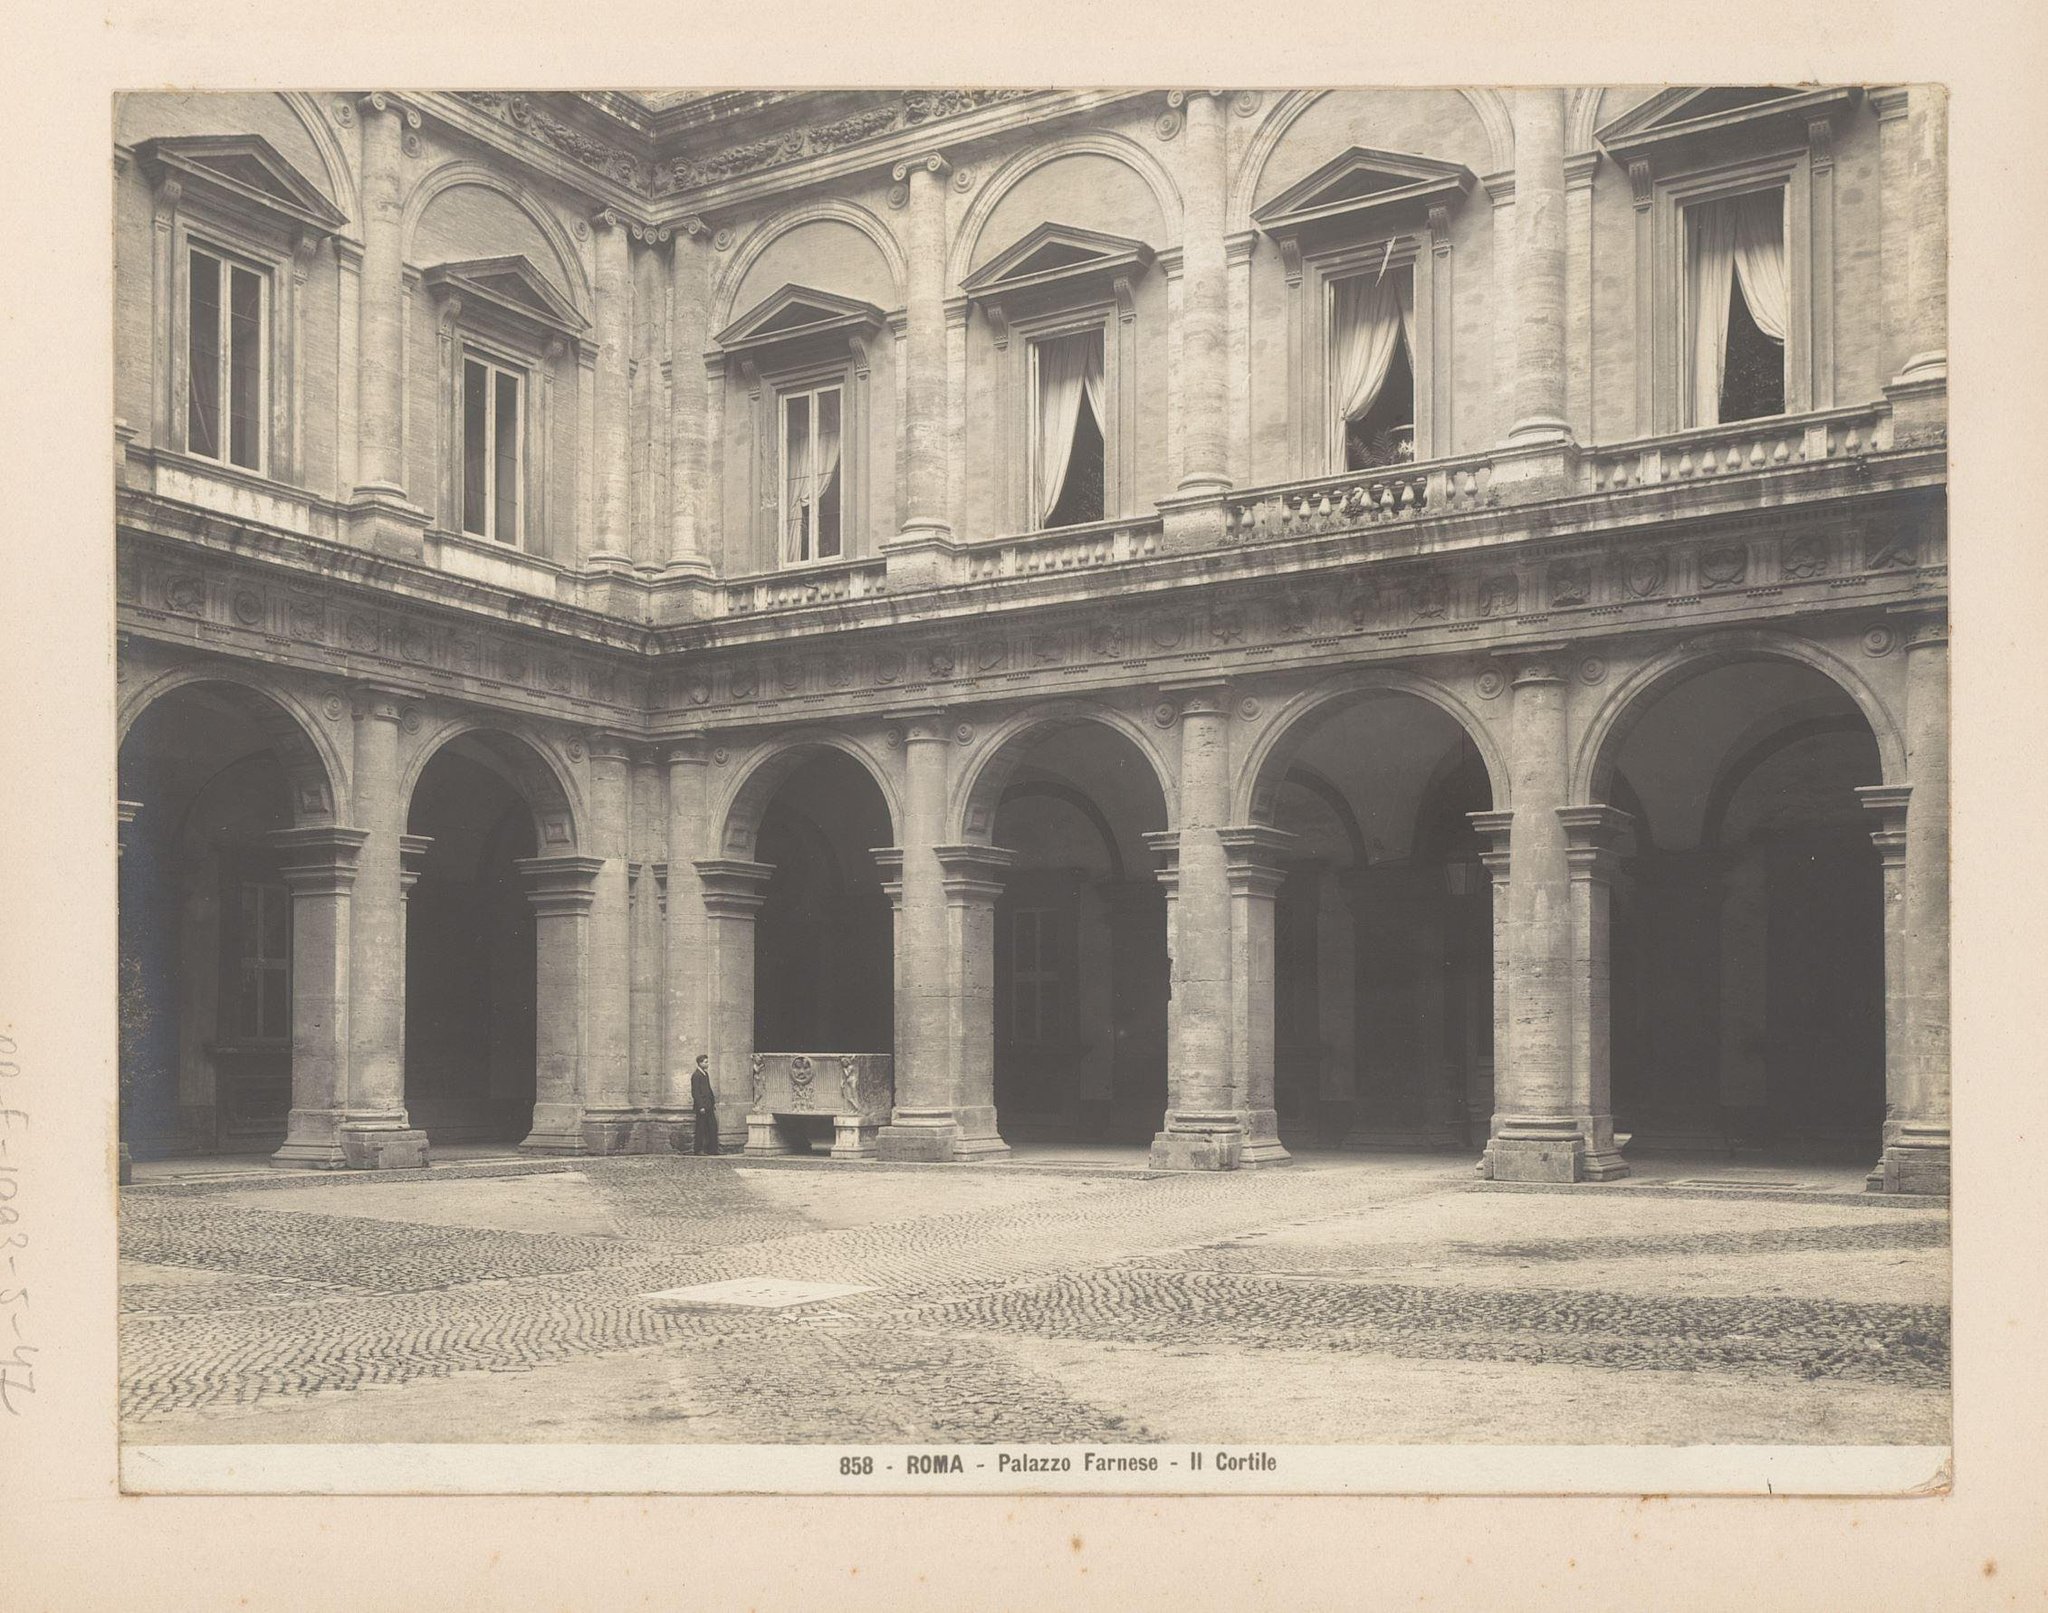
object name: photograph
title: Roma - Palazzo Farnese - Il Cortile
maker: giacomo brogi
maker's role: fotograaf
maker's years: 1822-1881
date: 1860-1881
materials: paper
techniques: gelatin silver print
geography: rome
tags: palace, courtyard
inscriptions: number: ‘858’